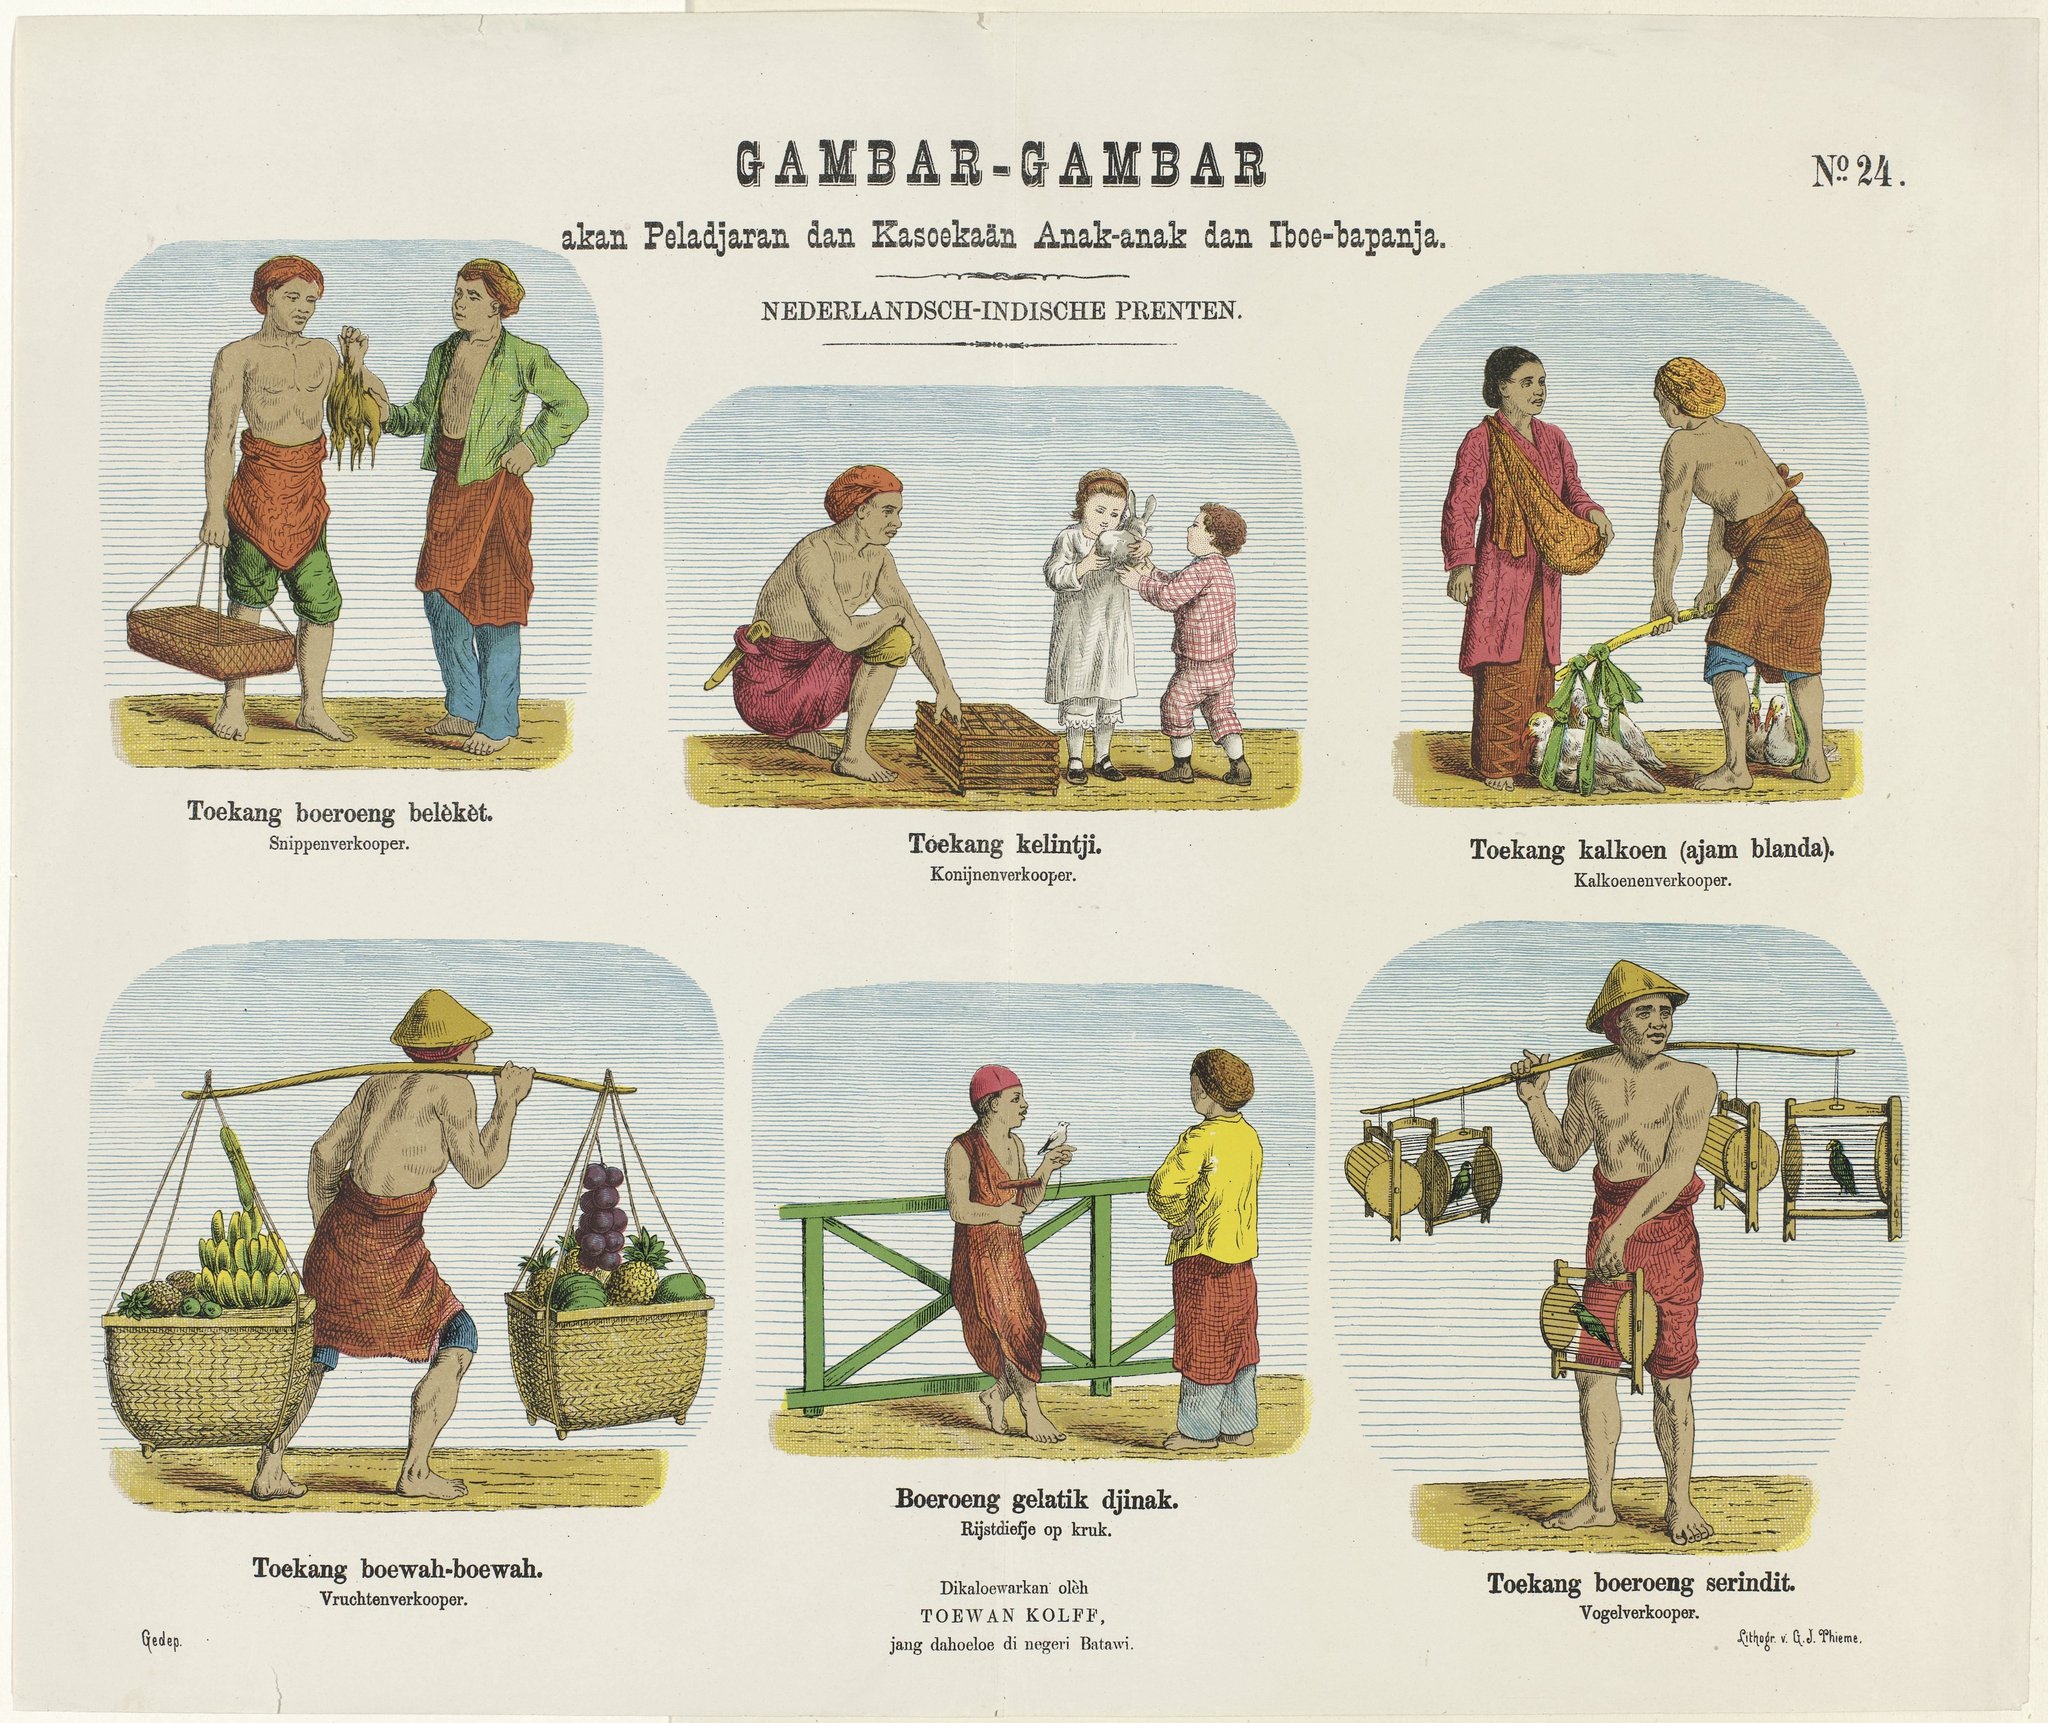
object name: print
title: Handelaren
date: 1868-1881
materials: paper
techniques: lithograph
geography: leiden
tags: asiatic races and peoples, street-trader, merchant, salesman, dutch east indies, the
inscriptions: collector's mark: Lugt 2760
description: Blad met zes voorstellingen van verkopers van dieren en fruit in de voormalige kolonie Nederlands-Indië, zoals een konijnen-, vogel- en fruitverkoper. Onder elke afbeelding een onderschrift in het Maleis en het Nederlands. Genummerd rechtsboven: No. 24.